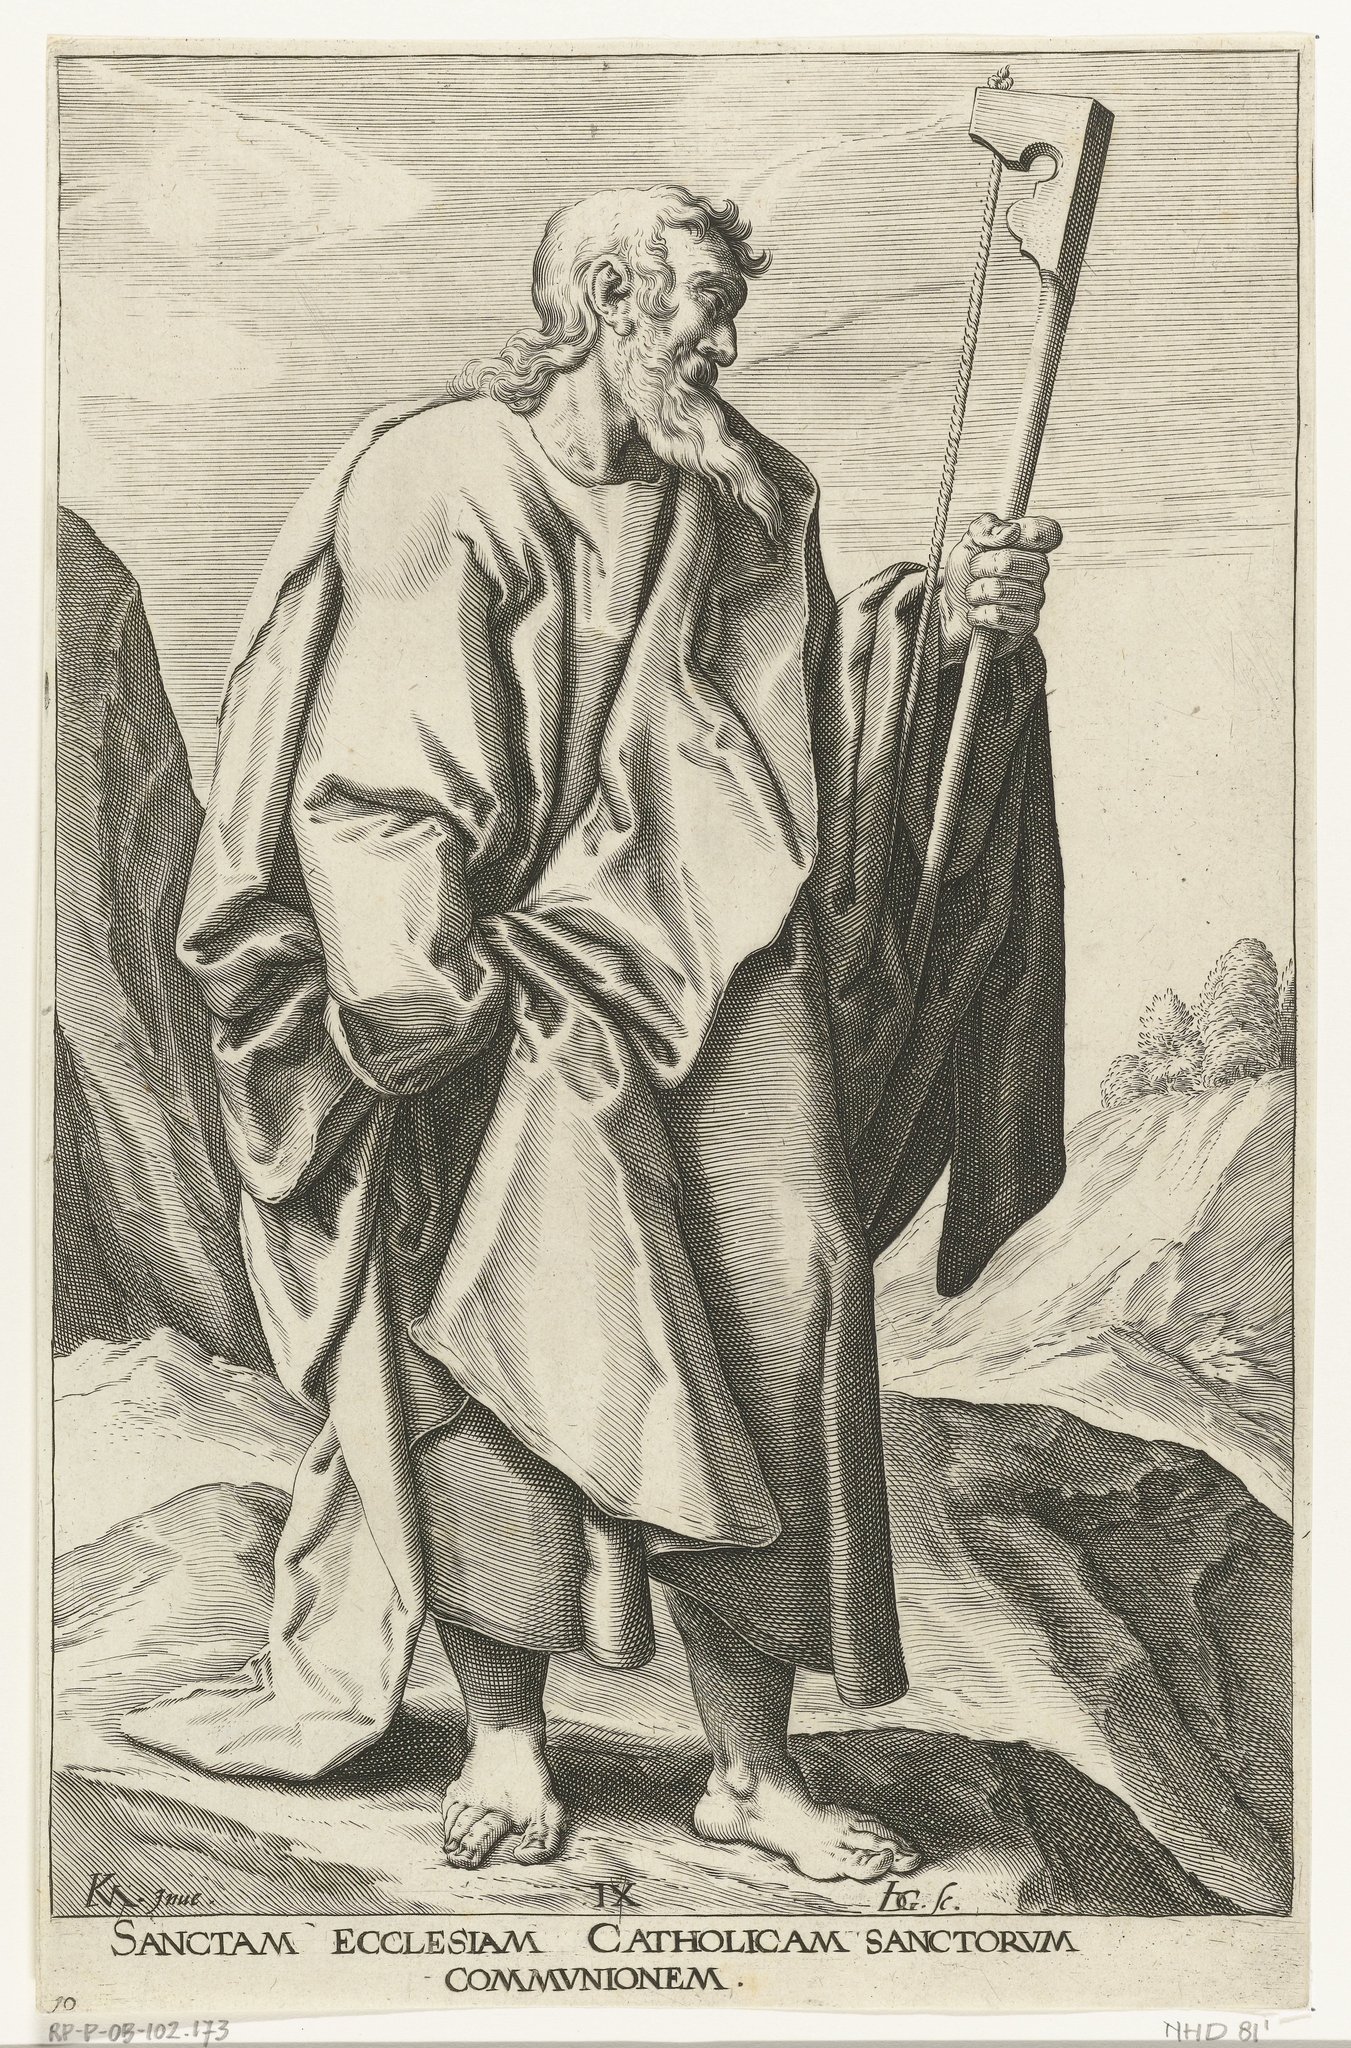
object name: print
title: Christus, de twaalf apostelen en de heilige Paulus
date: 1591-1592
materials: paper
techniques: engraving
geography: amsterdam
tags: the apostle james the less, first bishop of jerusalem; possible attributes: book, fuller's club, scroll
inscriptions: collector's mark: Lugt 2228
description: Deze prent is onderdeel van een serie van 14 prenten, elk bestaand uit een beeltenis ten voeten uit van een apostel, Christus of Paulus met typerende attributen en een onderschrift in Latijn.